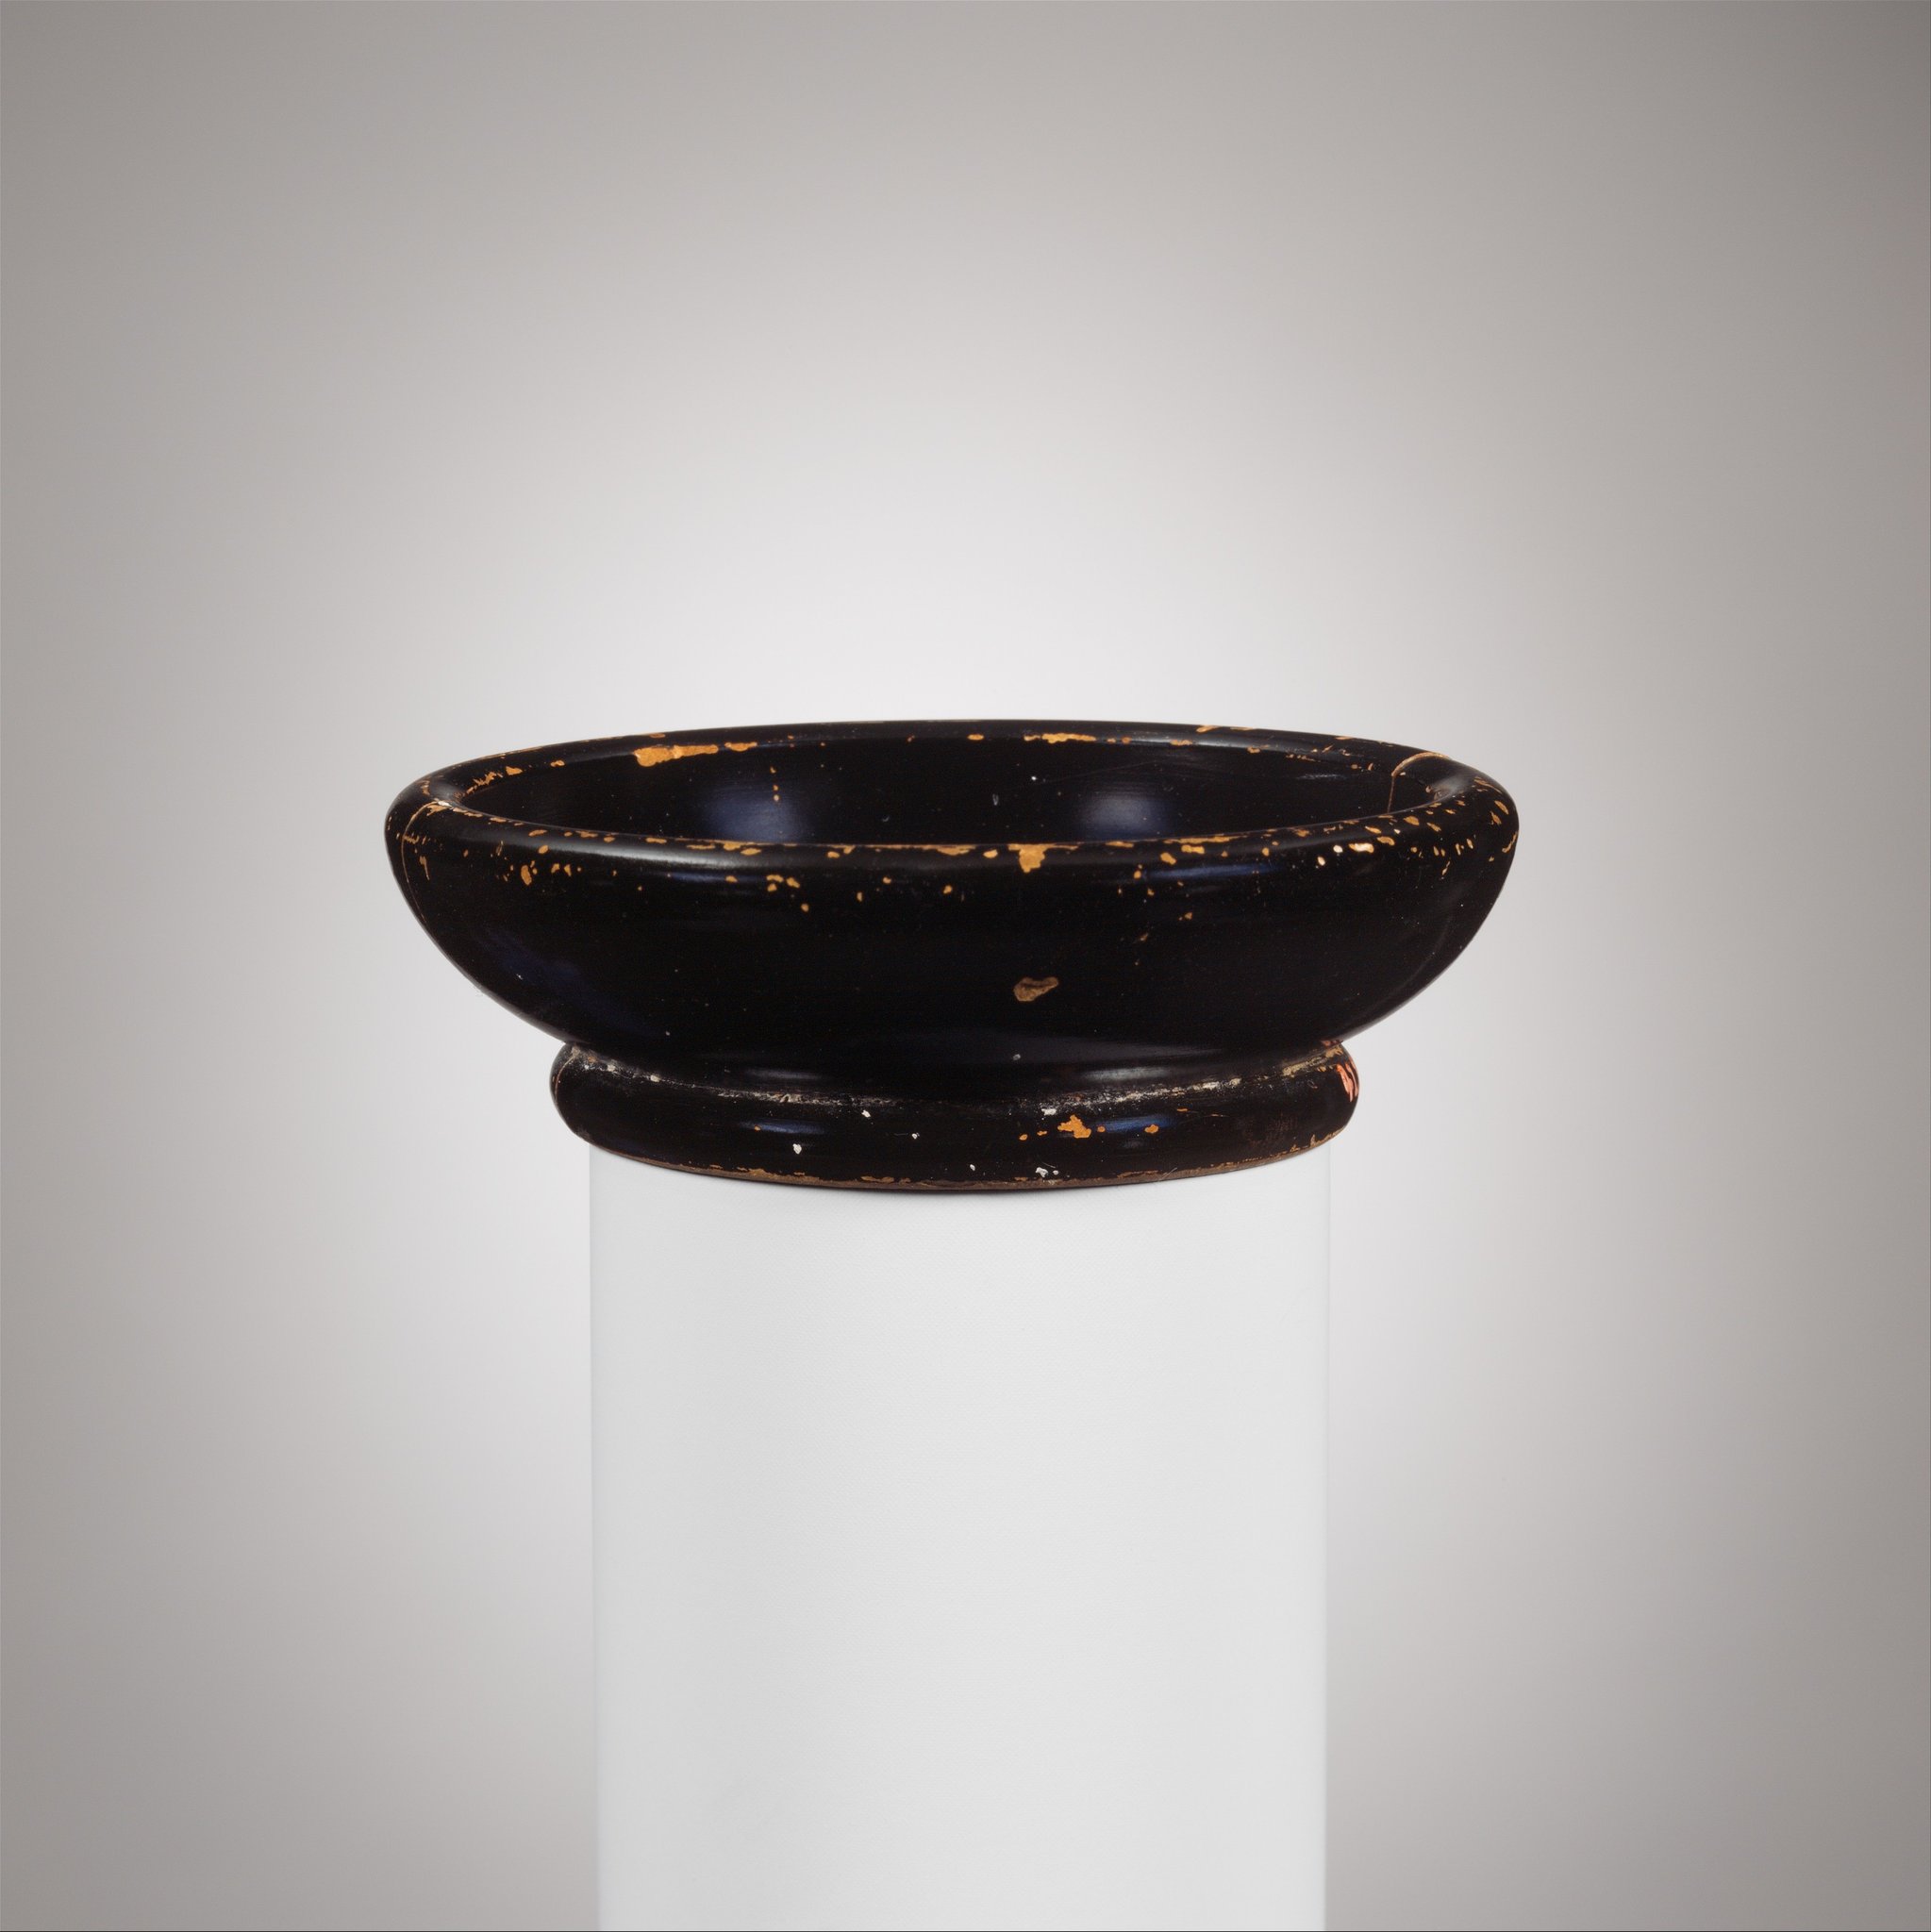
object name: dish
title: Terracotta dish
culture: greek, attic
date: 500-401 BCE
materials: terracotta